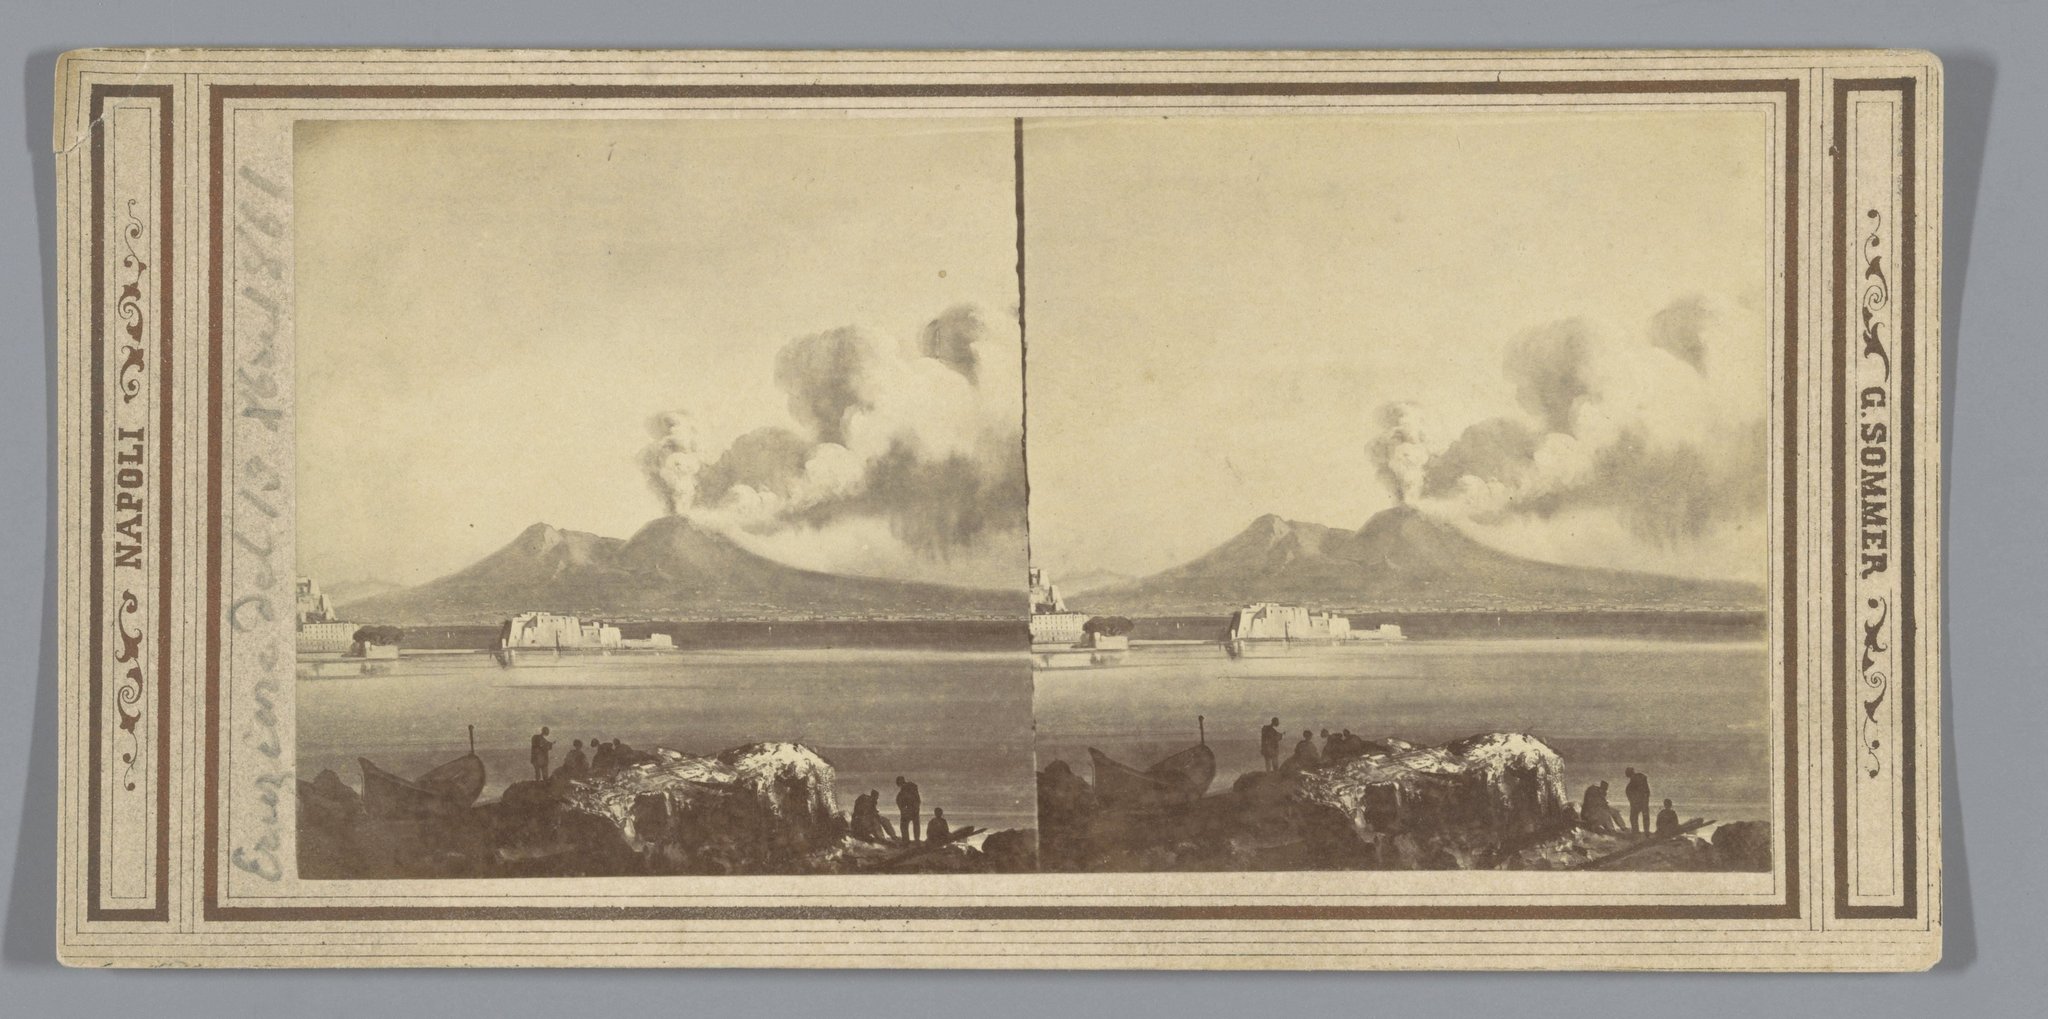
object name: reproduction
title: Napoli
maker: giorgio sommer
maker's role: fotograaf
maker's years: 1834-1914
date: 1860-1880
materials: cardboard, photographic support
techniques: albumen print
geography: naples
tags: eruption (of volcano), mount vesuvius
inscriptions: number: ‘K. 16.’, inscription: ‘Eruzione del 13 Xbre 1861’